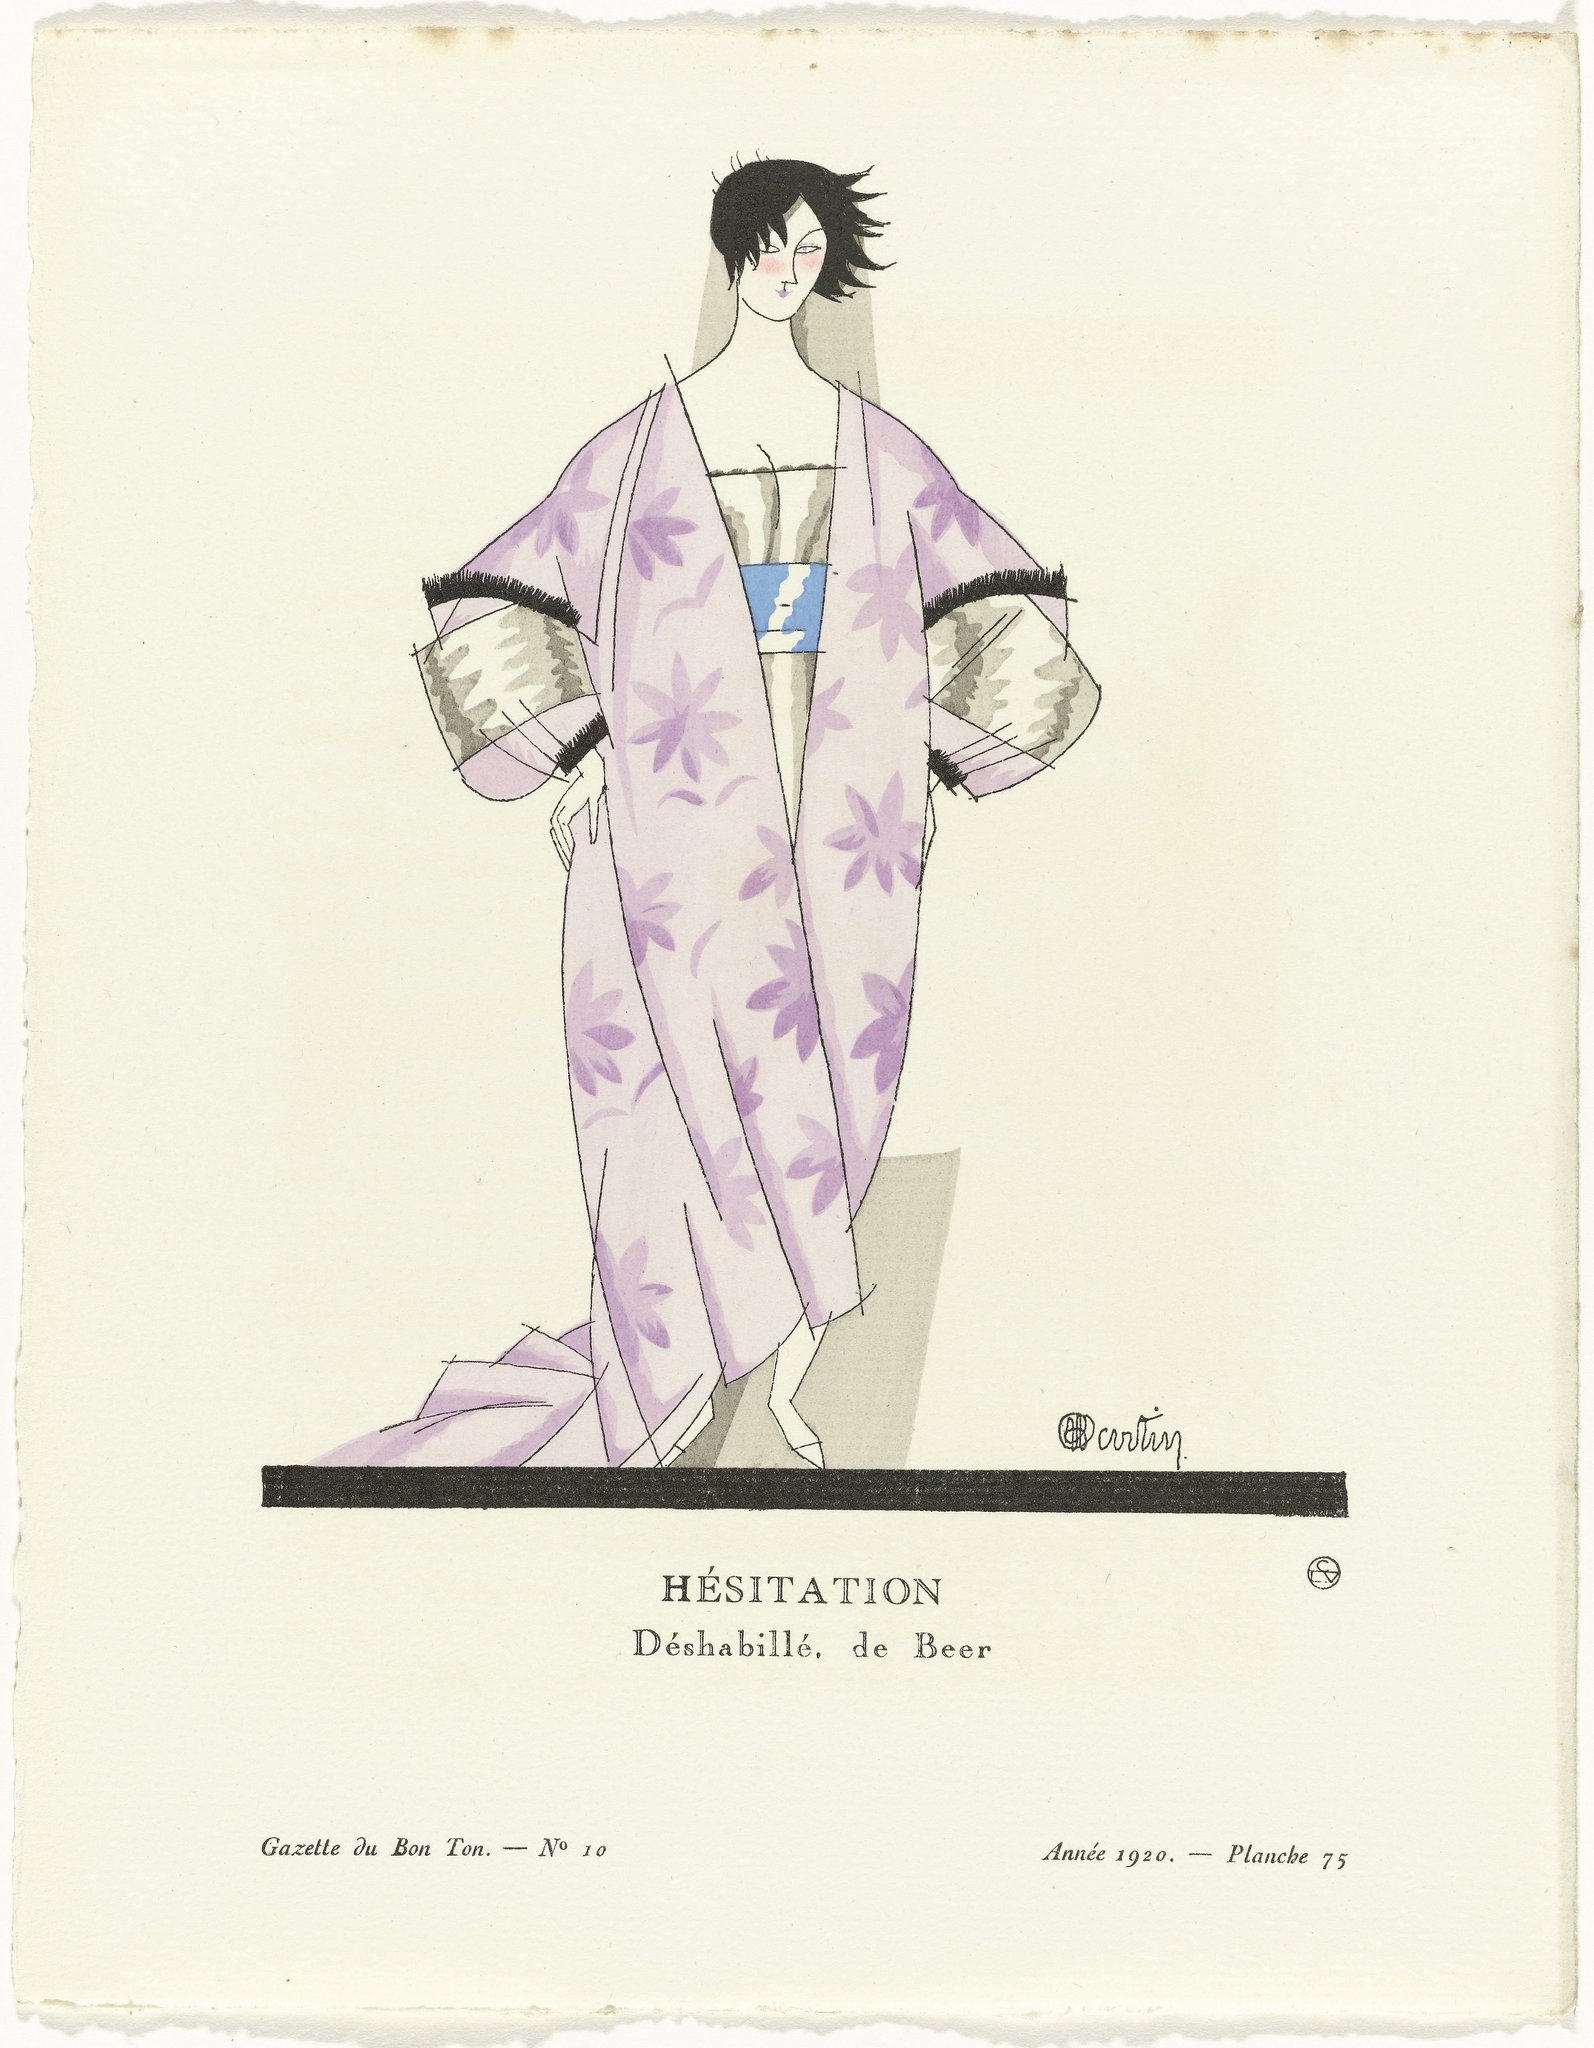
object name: fashion print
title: Gazette du Bon Ton, 1920 - No. 10, Pl. 75: Hésitation / Déshabillé, de Beer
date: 1920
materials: paper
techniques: hand coloring, letterpress printing, lithograph, pochoir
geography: paris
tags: lace (+ women's clothes), dress, gown (tea-gown) (+ women's clothes), fashion plates, belt, girdle, waistband (+ women's clothes)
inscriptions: caption: ‘HÉSITATION / Déshabillé. de Beer.’, inscription: ‘Gazette du Bon Ton. - No 10 / Année 1920. - Planche 75’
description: Staande vrouw gekleed in 'teagown' van Beer, met om het middel een ceintuur van lint. Planche 75 uit Gazette du Bon Ton 1920, No. 10. Uitleg over de kleding op pagina "Explication des Planches".